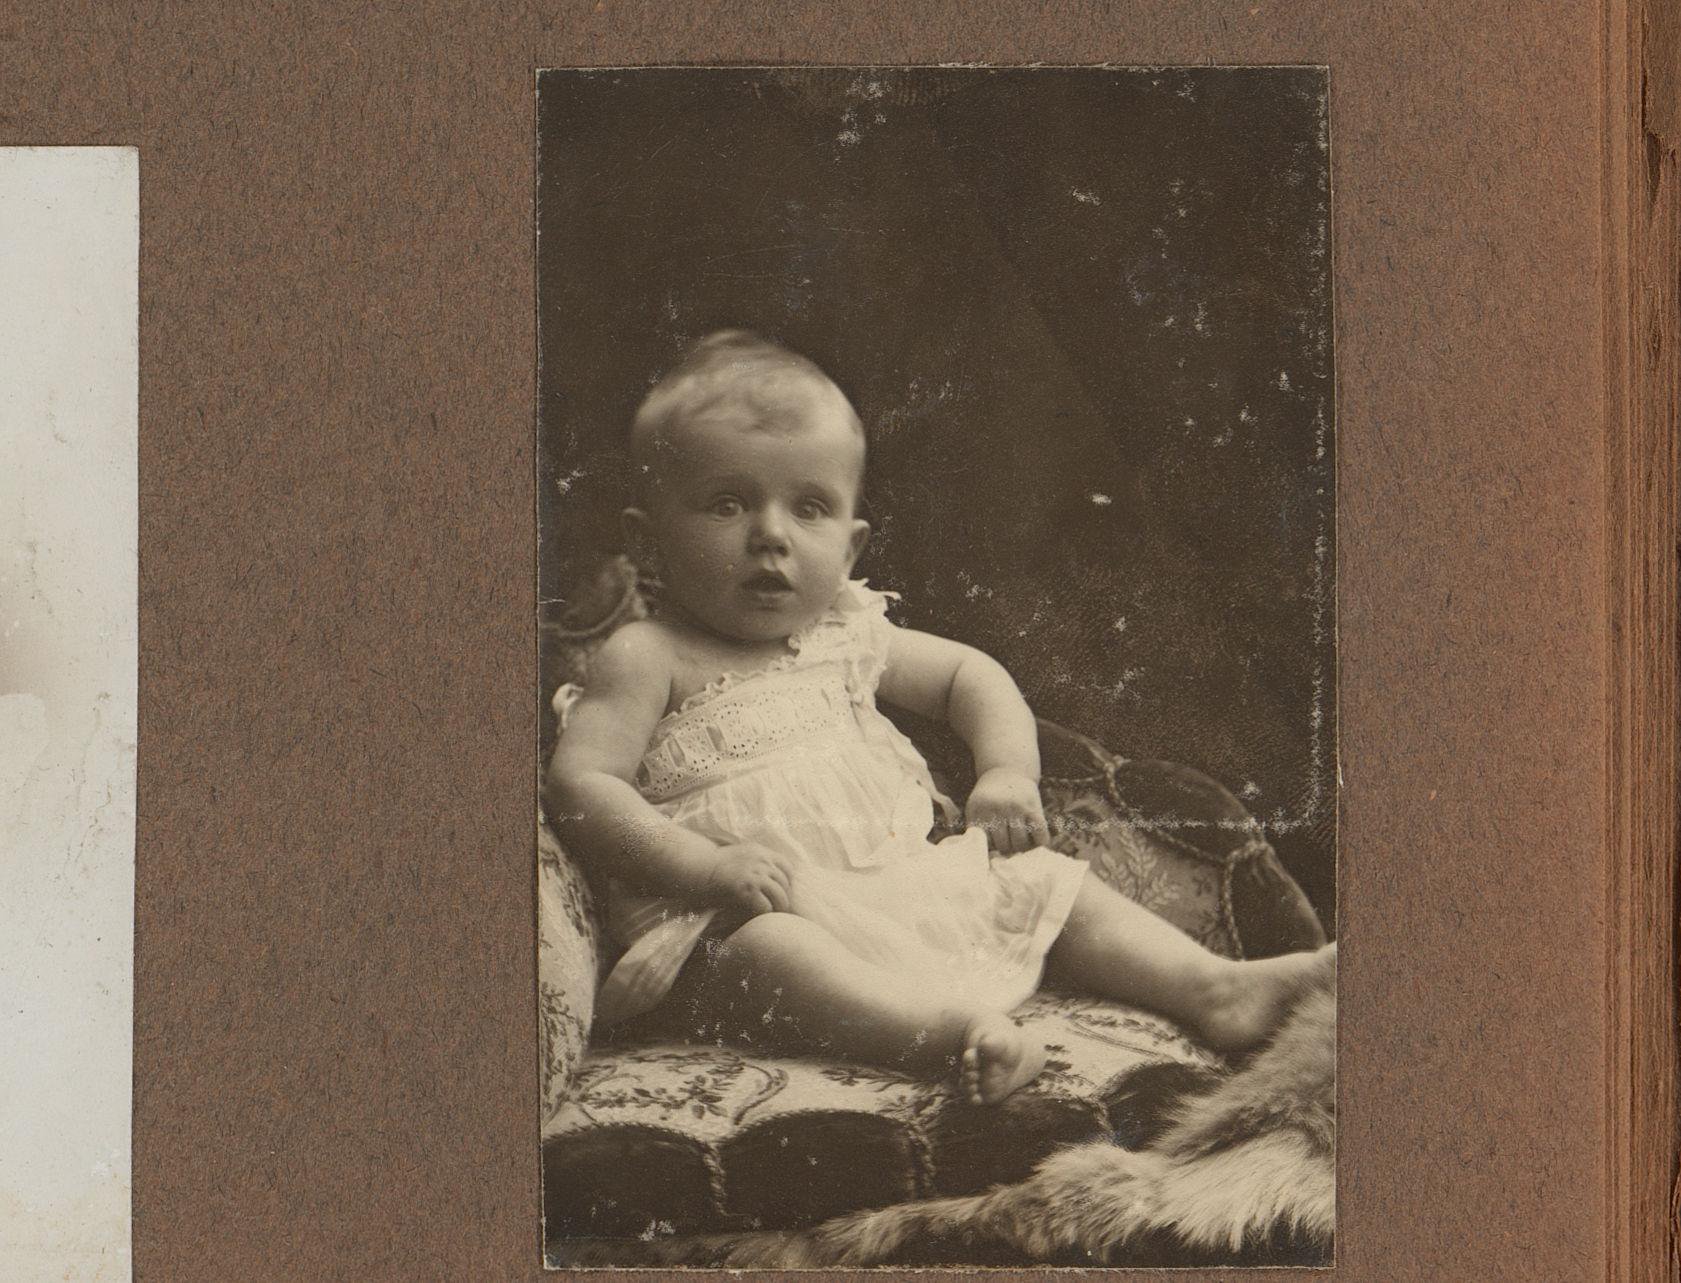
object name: photograph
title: Portret van jong zittend kind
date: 1870-1920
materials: photographic support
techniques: photography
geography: amsterdam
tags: netherlands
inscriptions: inscription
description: Foto op bruin albumblad 37 van familiealbum van Alphons Diepenbrock.